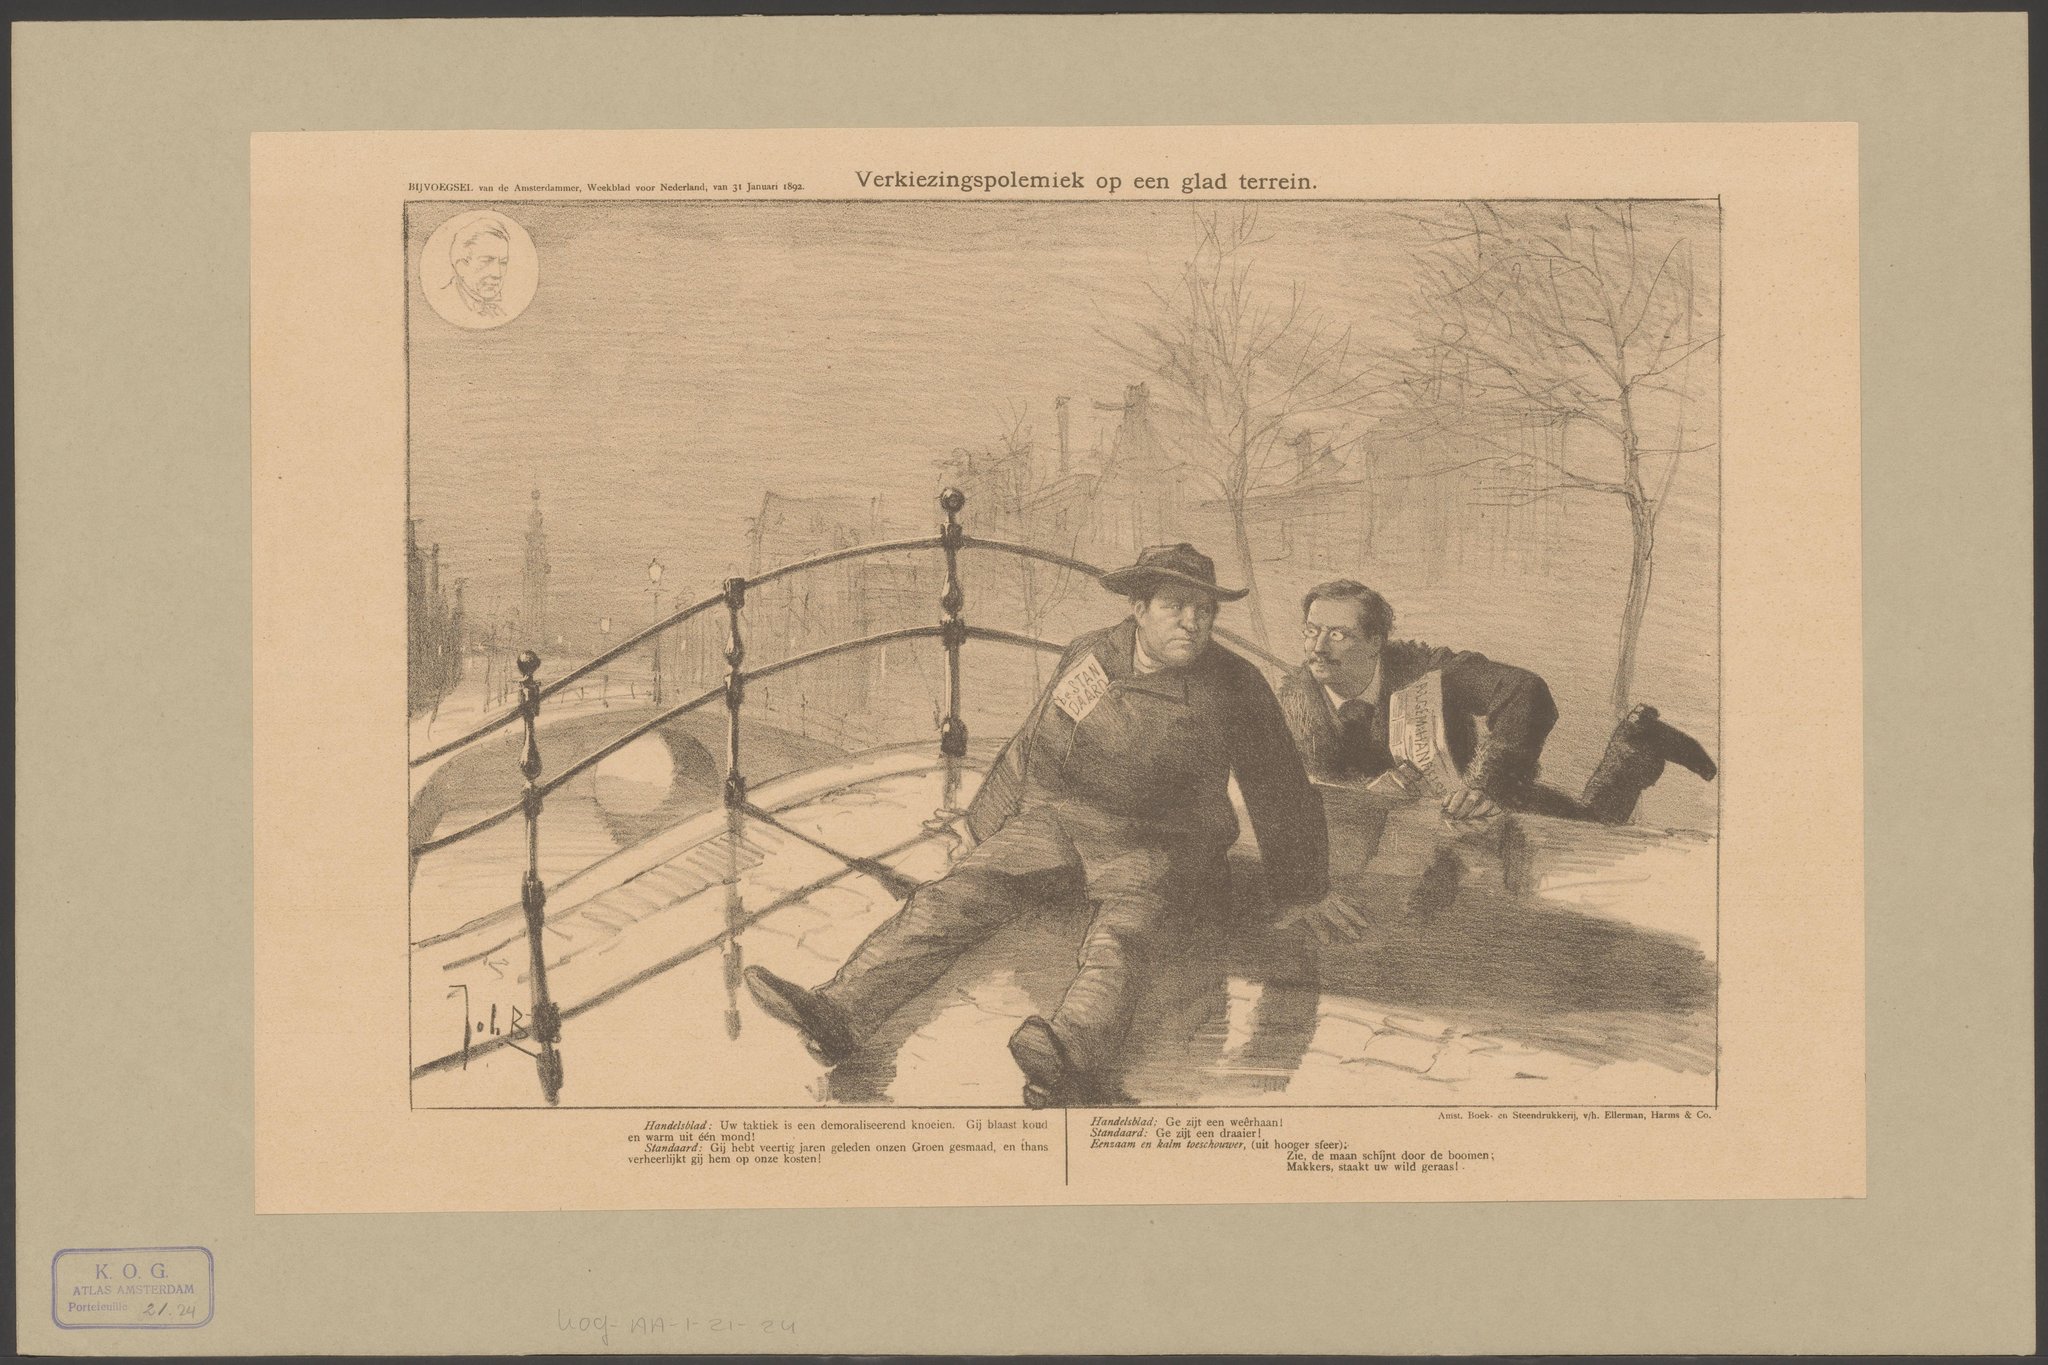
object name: cartoon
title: Verkiezingspolemiek op een glad terrein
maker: johan braakensiek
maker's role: draughtsman, print maker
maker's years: 1858-1940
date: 1892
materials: paper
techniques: letterpress printing, lithograph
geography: amsterdam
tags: groningen (province), utrecht, the hague, abraham kuyper, guillaume groen van prinsterer, ice ~ freezing weather, canals, waters (in city), newspaper, news-sheet, political caricatures and satires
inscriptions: collector's mark: Lugt 1641b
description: Voorvechters van de kranten De Standaard (Abraham Kuyper) en het Algemeen Handelsblad (Johan d'Aulnis de Bourouill) uitgegleden op de straat van een bevroren brug over de Prinsengracht in Amsterdam. Vanuit de maan kijkt Guillaume Groen van Prinsterer neer op het tafereel. Onderwerpsrubriek binnen de Atlas Amsterdam: Kiesverenigingen, Politieke partijen.